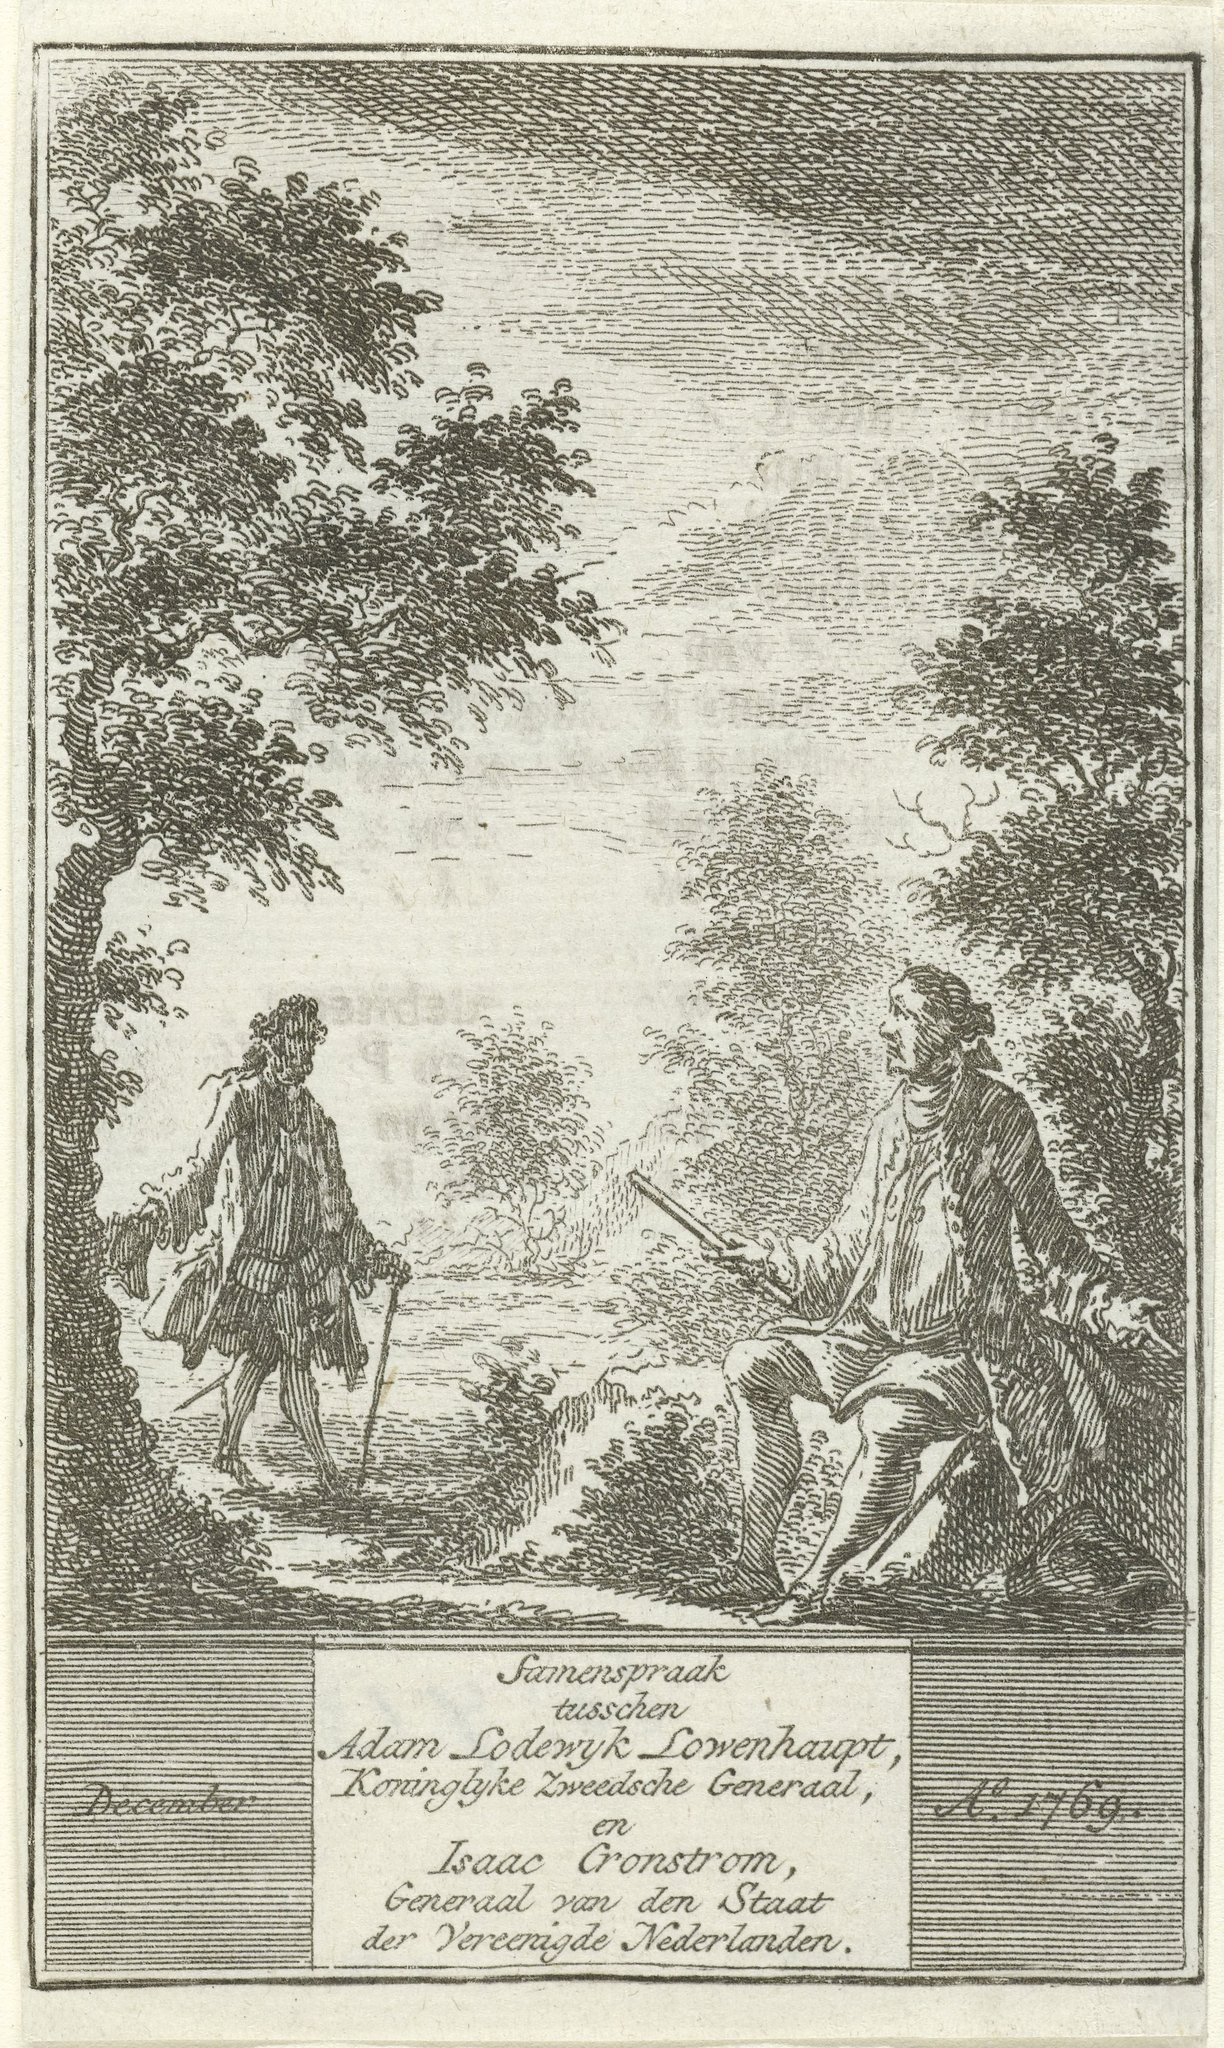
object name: print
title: Ontmoeting tussen twee historische figuren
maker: simon fokke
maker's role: draughtsman, print maker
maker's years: 1712-1784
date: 1722-1784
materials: paper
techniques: etching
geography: amsterdam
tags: meeting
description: De generalen Adam Lodewijk Lowenhaupt en Isaac Gronstrom ontmoeten elkaar in de buitenlucht. Onder de afbeelding een tekst met de datum december 1769.